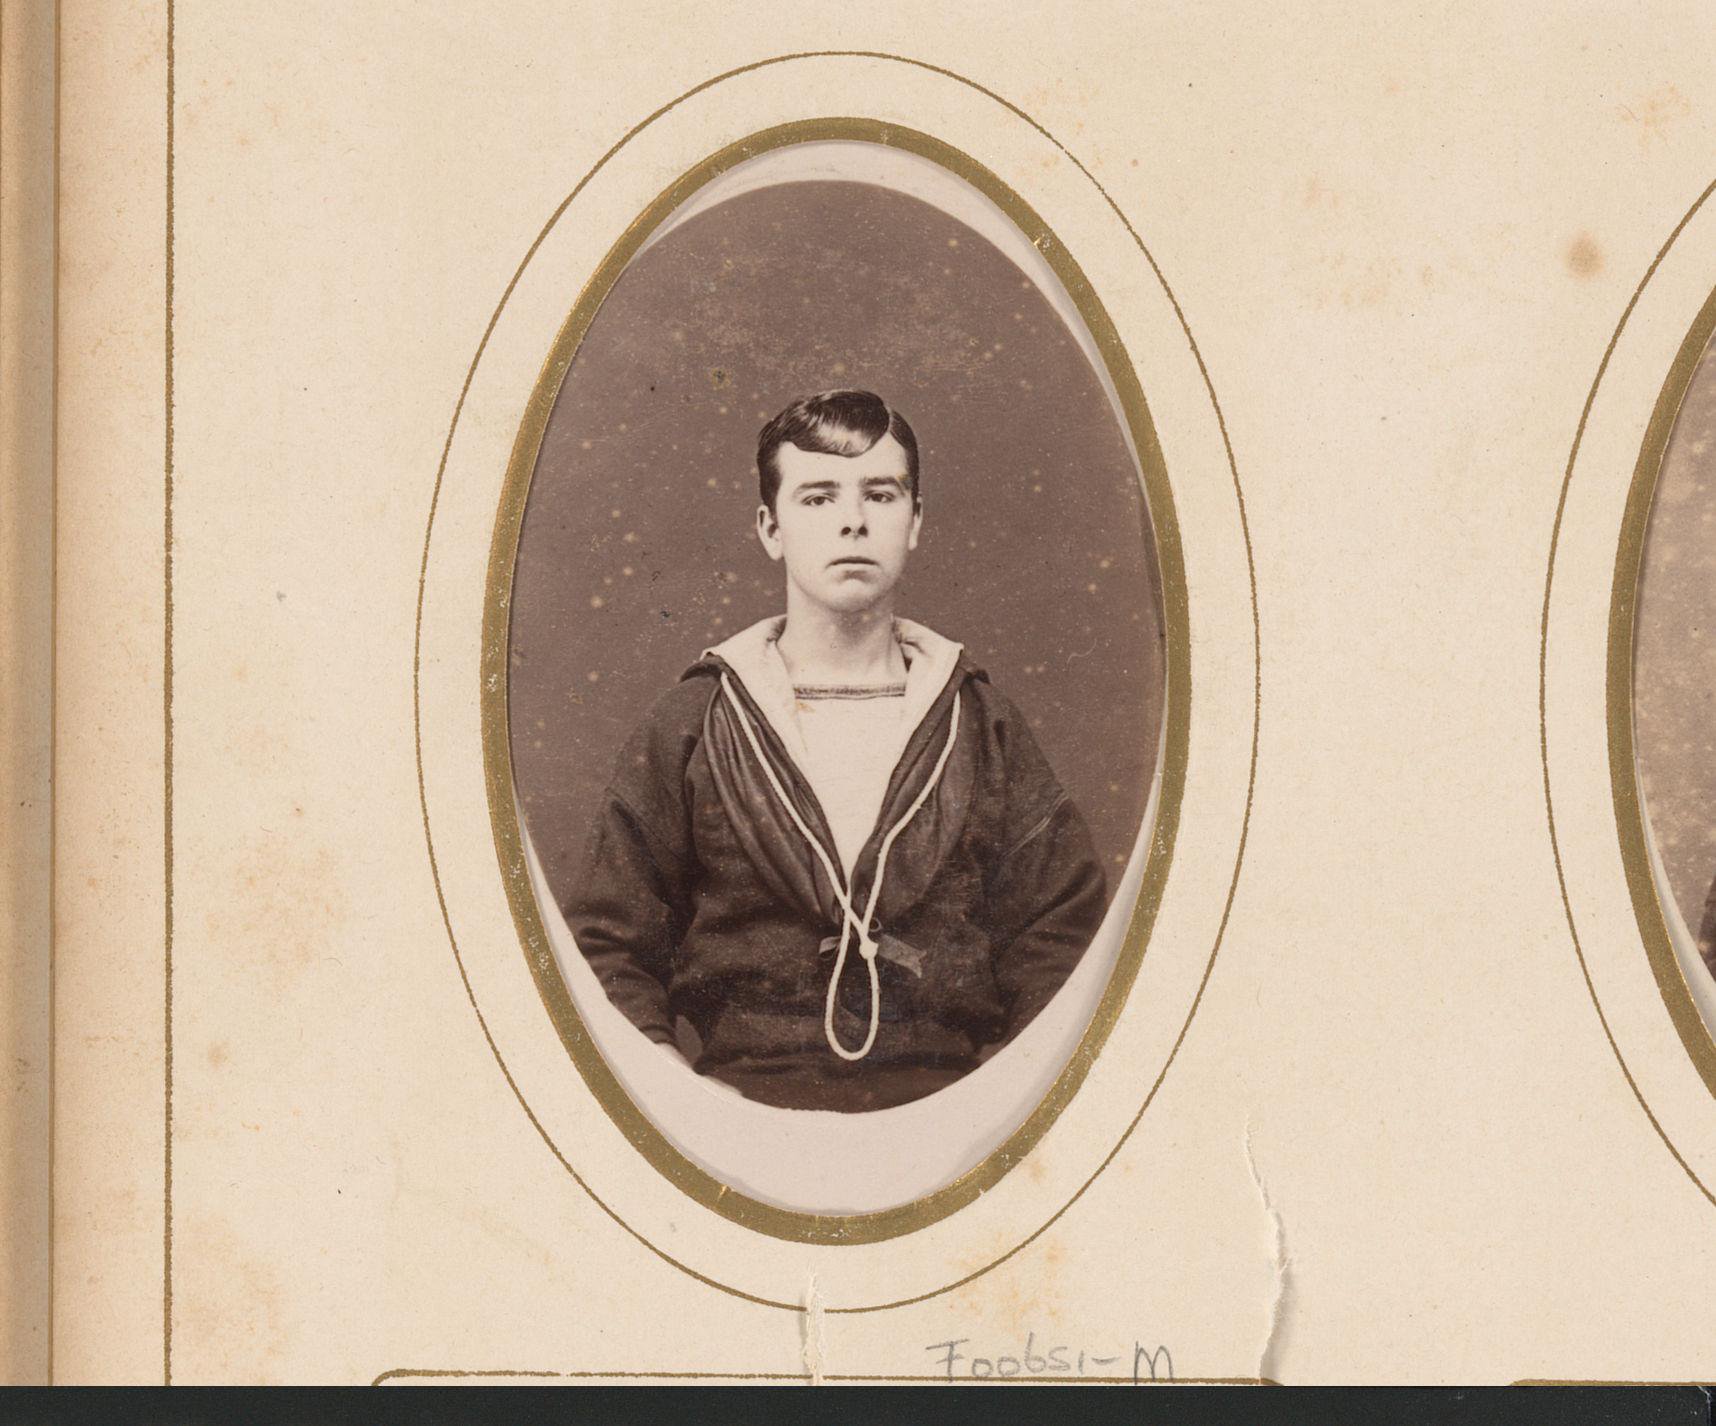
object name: carte de visite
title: Portret van een matroos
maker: saverio ciantar preziosi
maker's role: fotograaf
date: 1880-1915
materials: cardboard, photographic support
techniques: albumen print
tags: adult man, historical persons, seaman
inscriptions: inscription: ‘133 Strada Teatro, St. George Palace Square, Valletta’